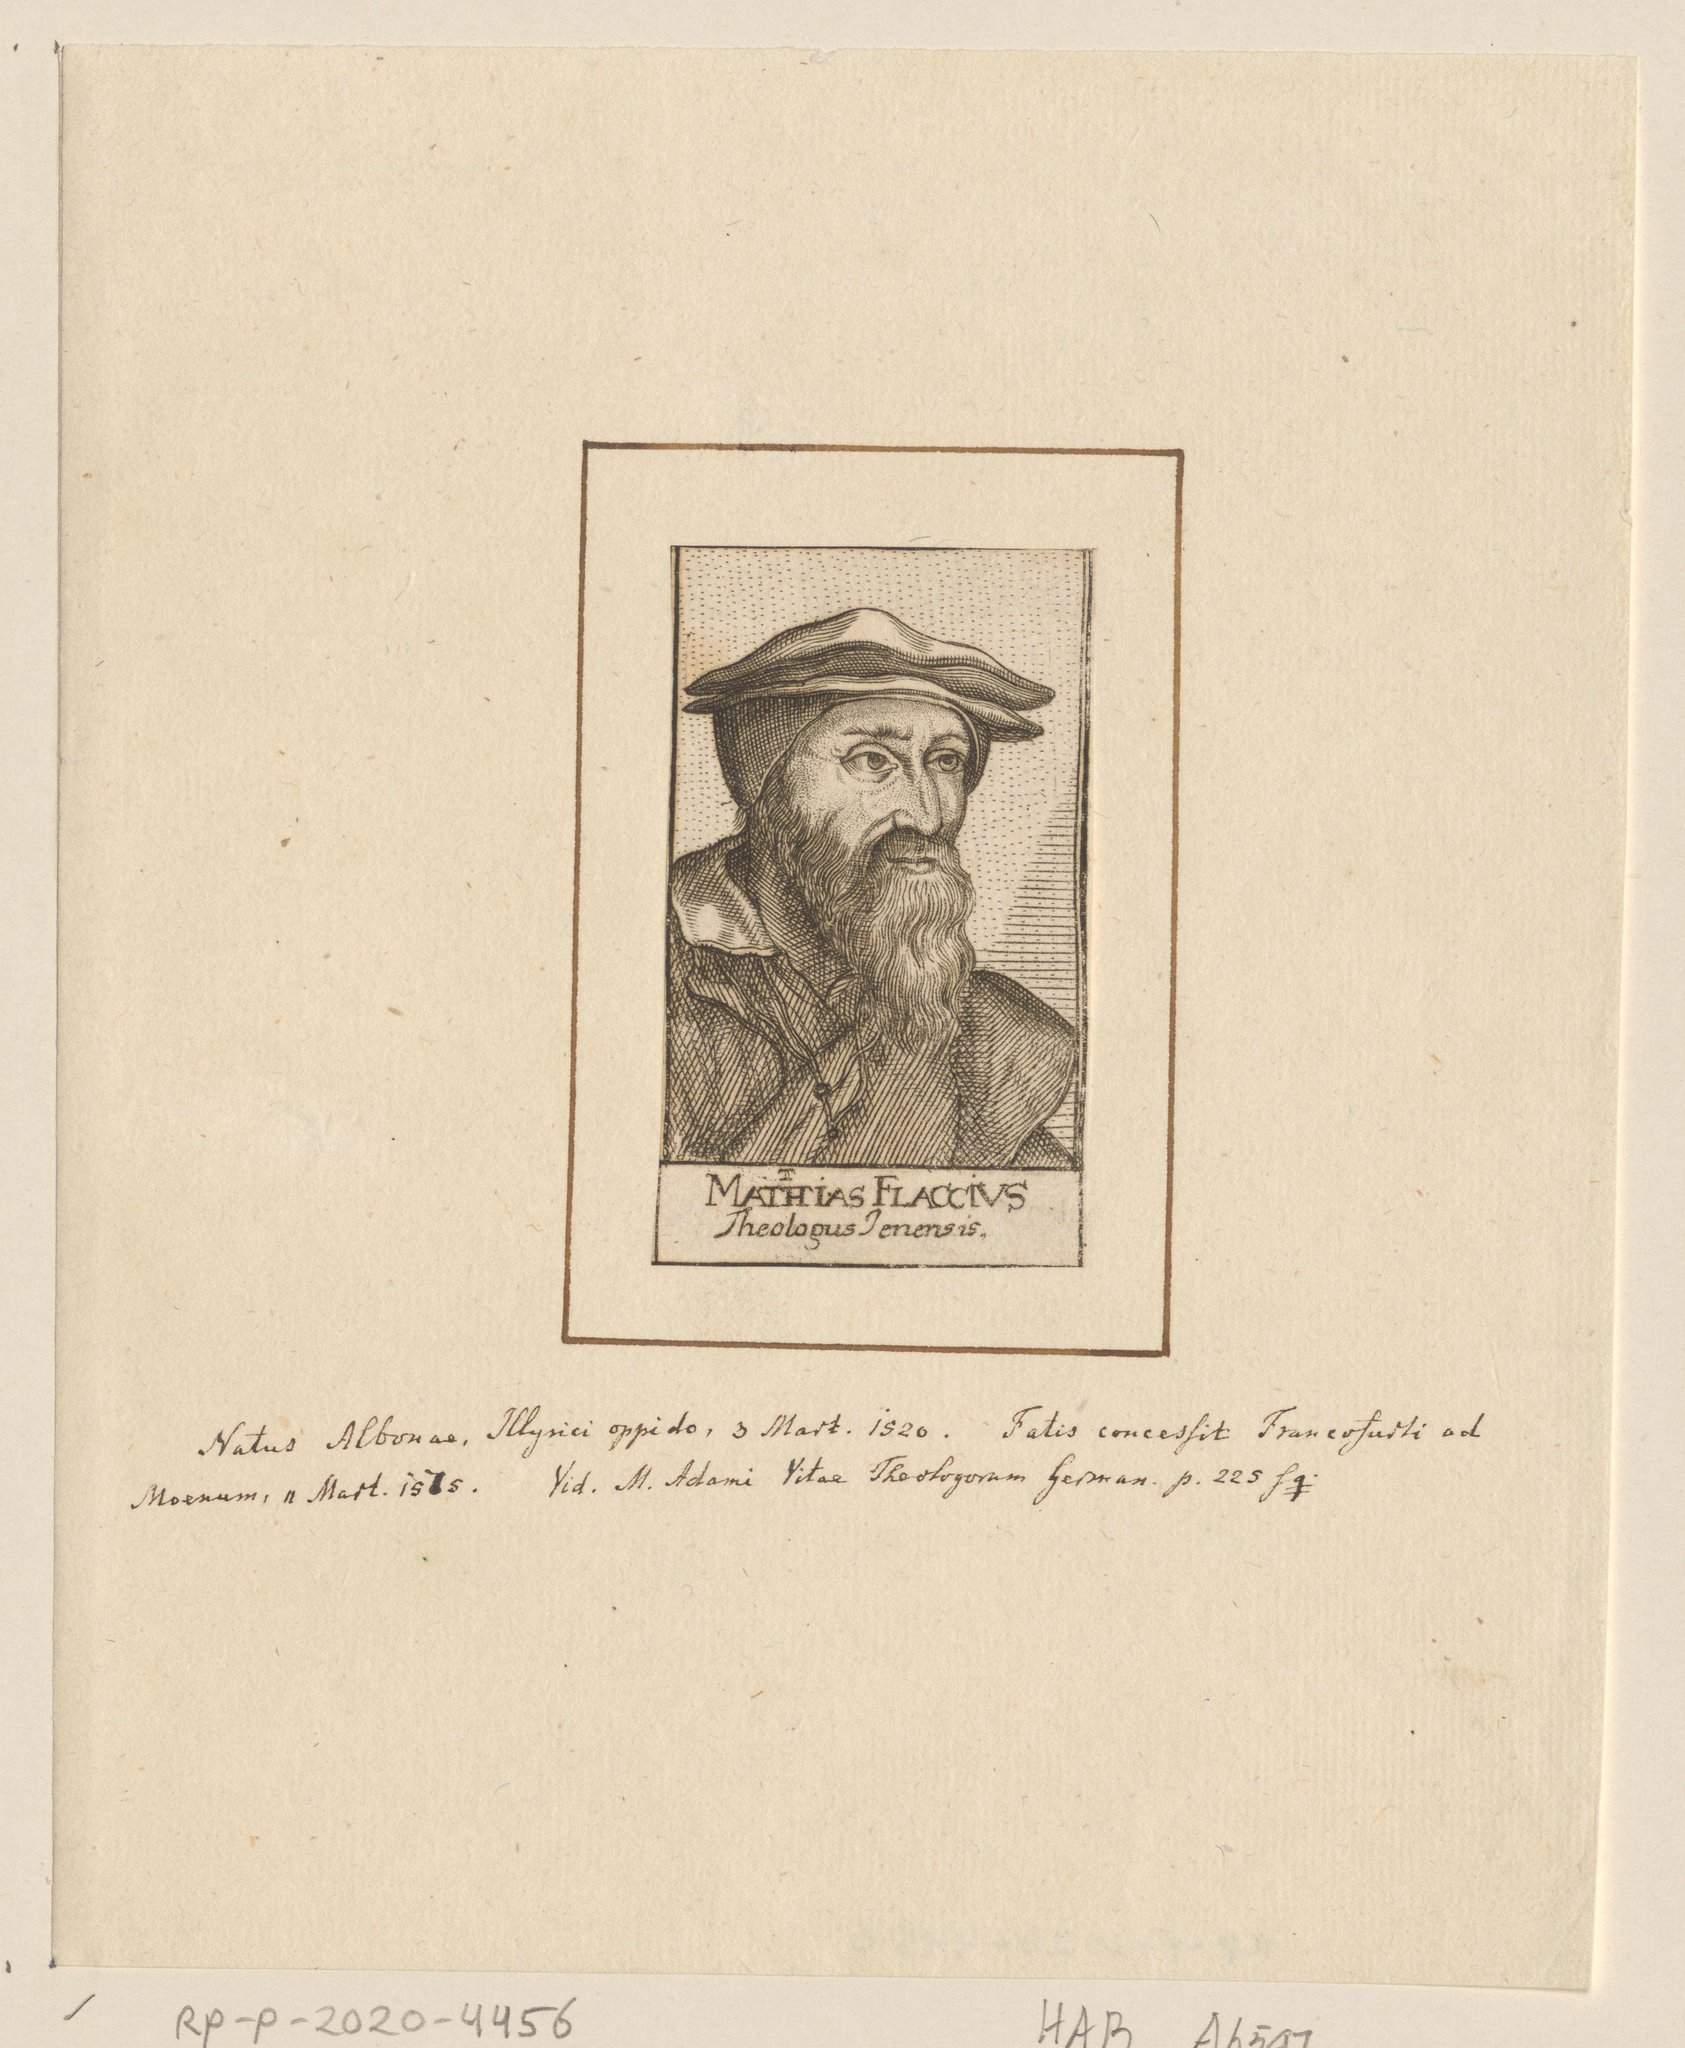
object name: book illustration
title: Portret van Matthias Flacius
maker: Anonymous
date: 1688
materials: paper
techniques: engraving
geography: germany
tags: theologian, historical persons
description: Prent waarschijnlijk uit: Freher, Paul. Theatrum virorum eruditione clarorum. Neurenberg: Johann Hoffmann, 1688.